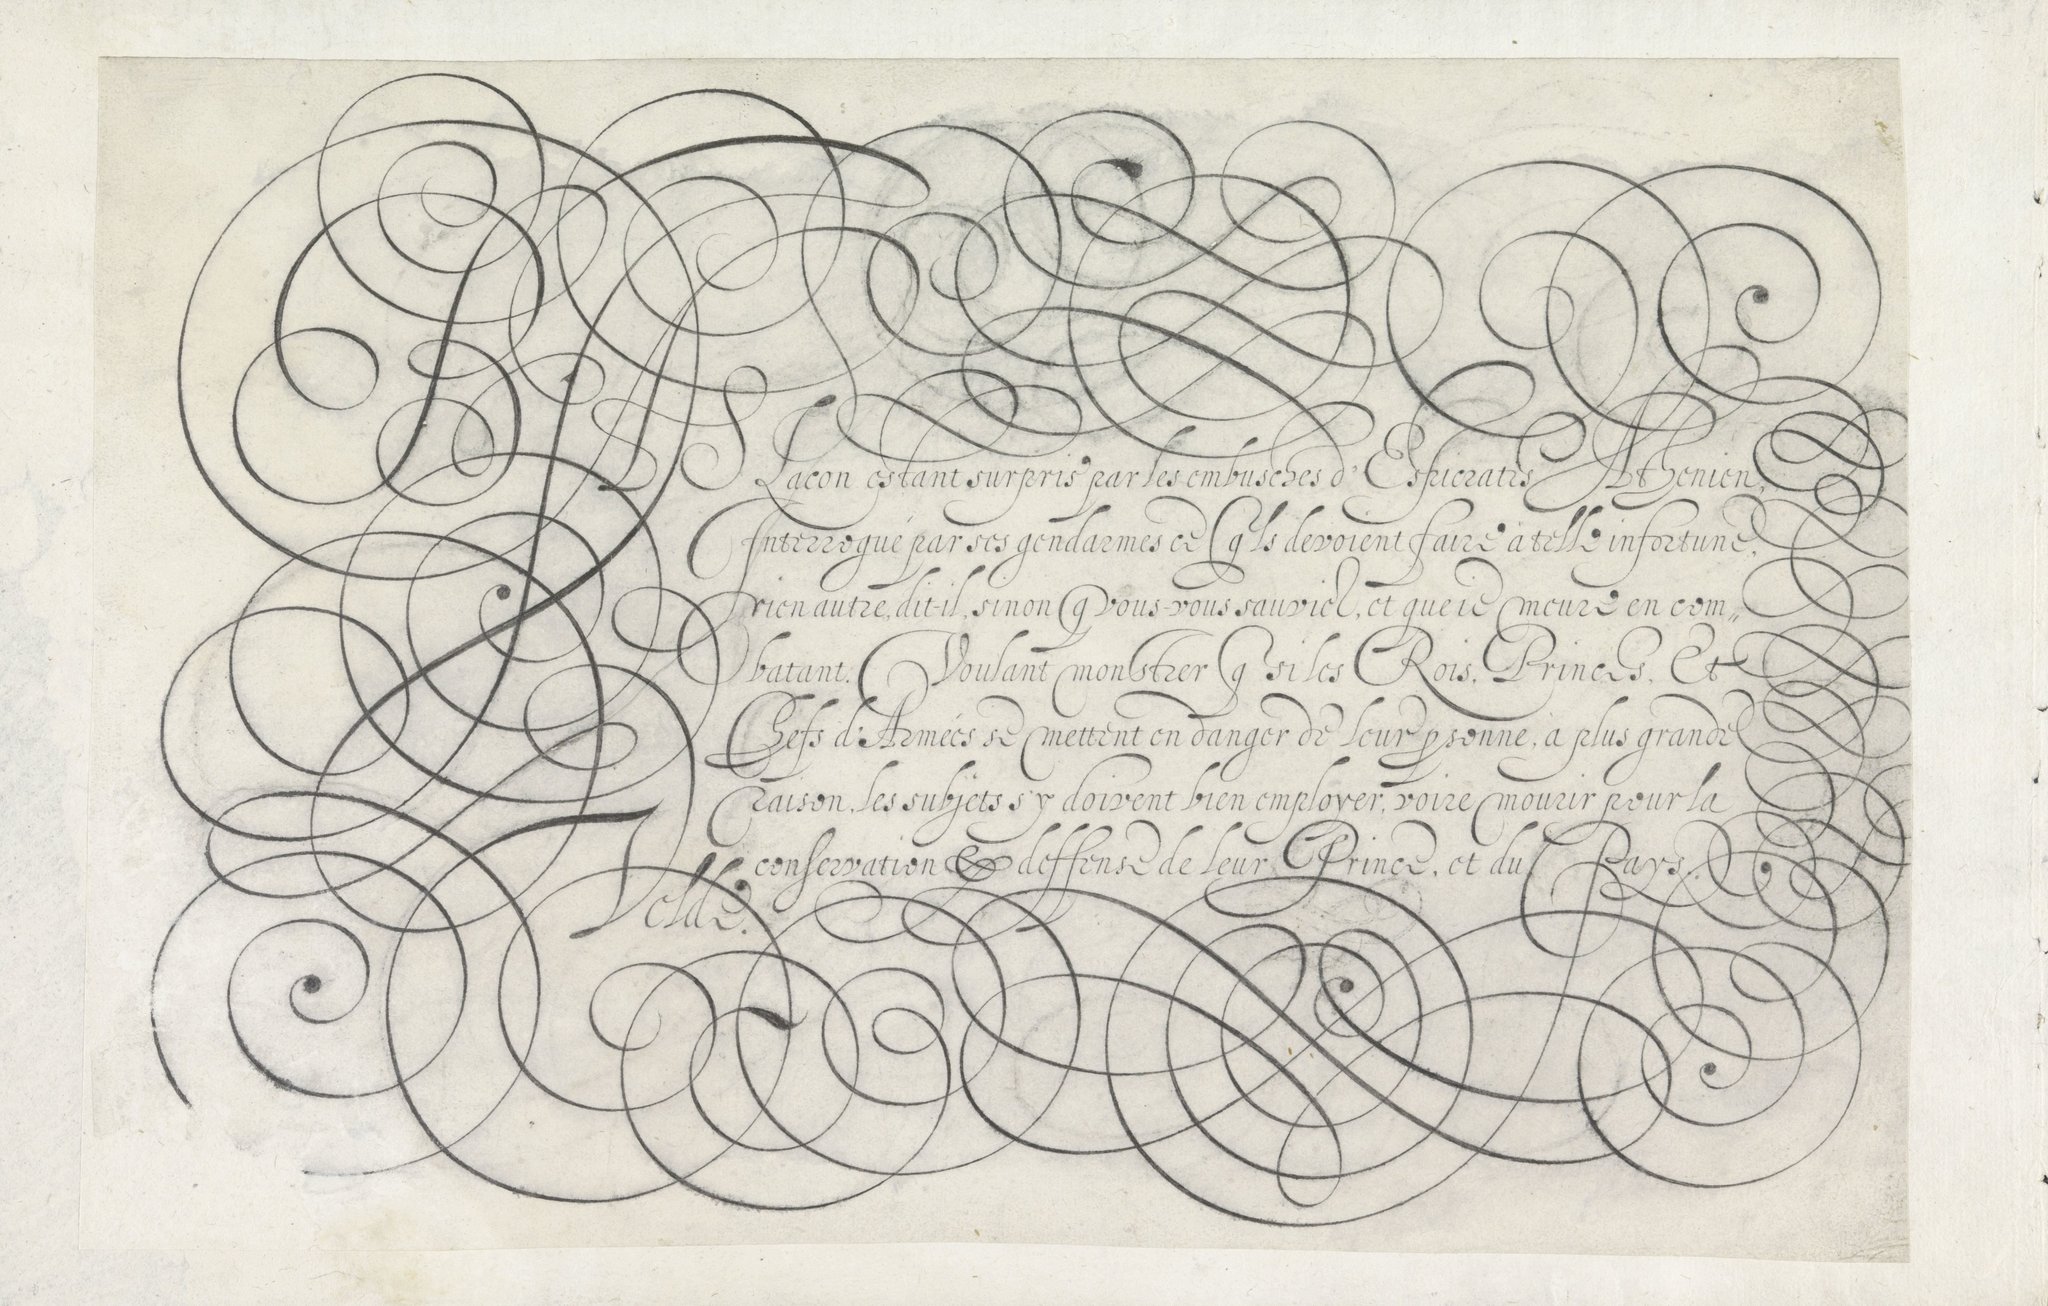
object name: album leaf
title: Spieghel der schrijfkonste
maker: jan van de velde (i)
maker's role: painter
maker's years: 1568-1623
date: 1605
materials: ink, paper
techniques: calligraphy, pen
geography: rotterdam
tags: calligraphy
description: Kalligrafische tekening met zeven regels tekst in het Frans: Bias Lacon estant surpris ... De tekst is omlijst met krulwerk. De tekening maakt deel uit van een album.